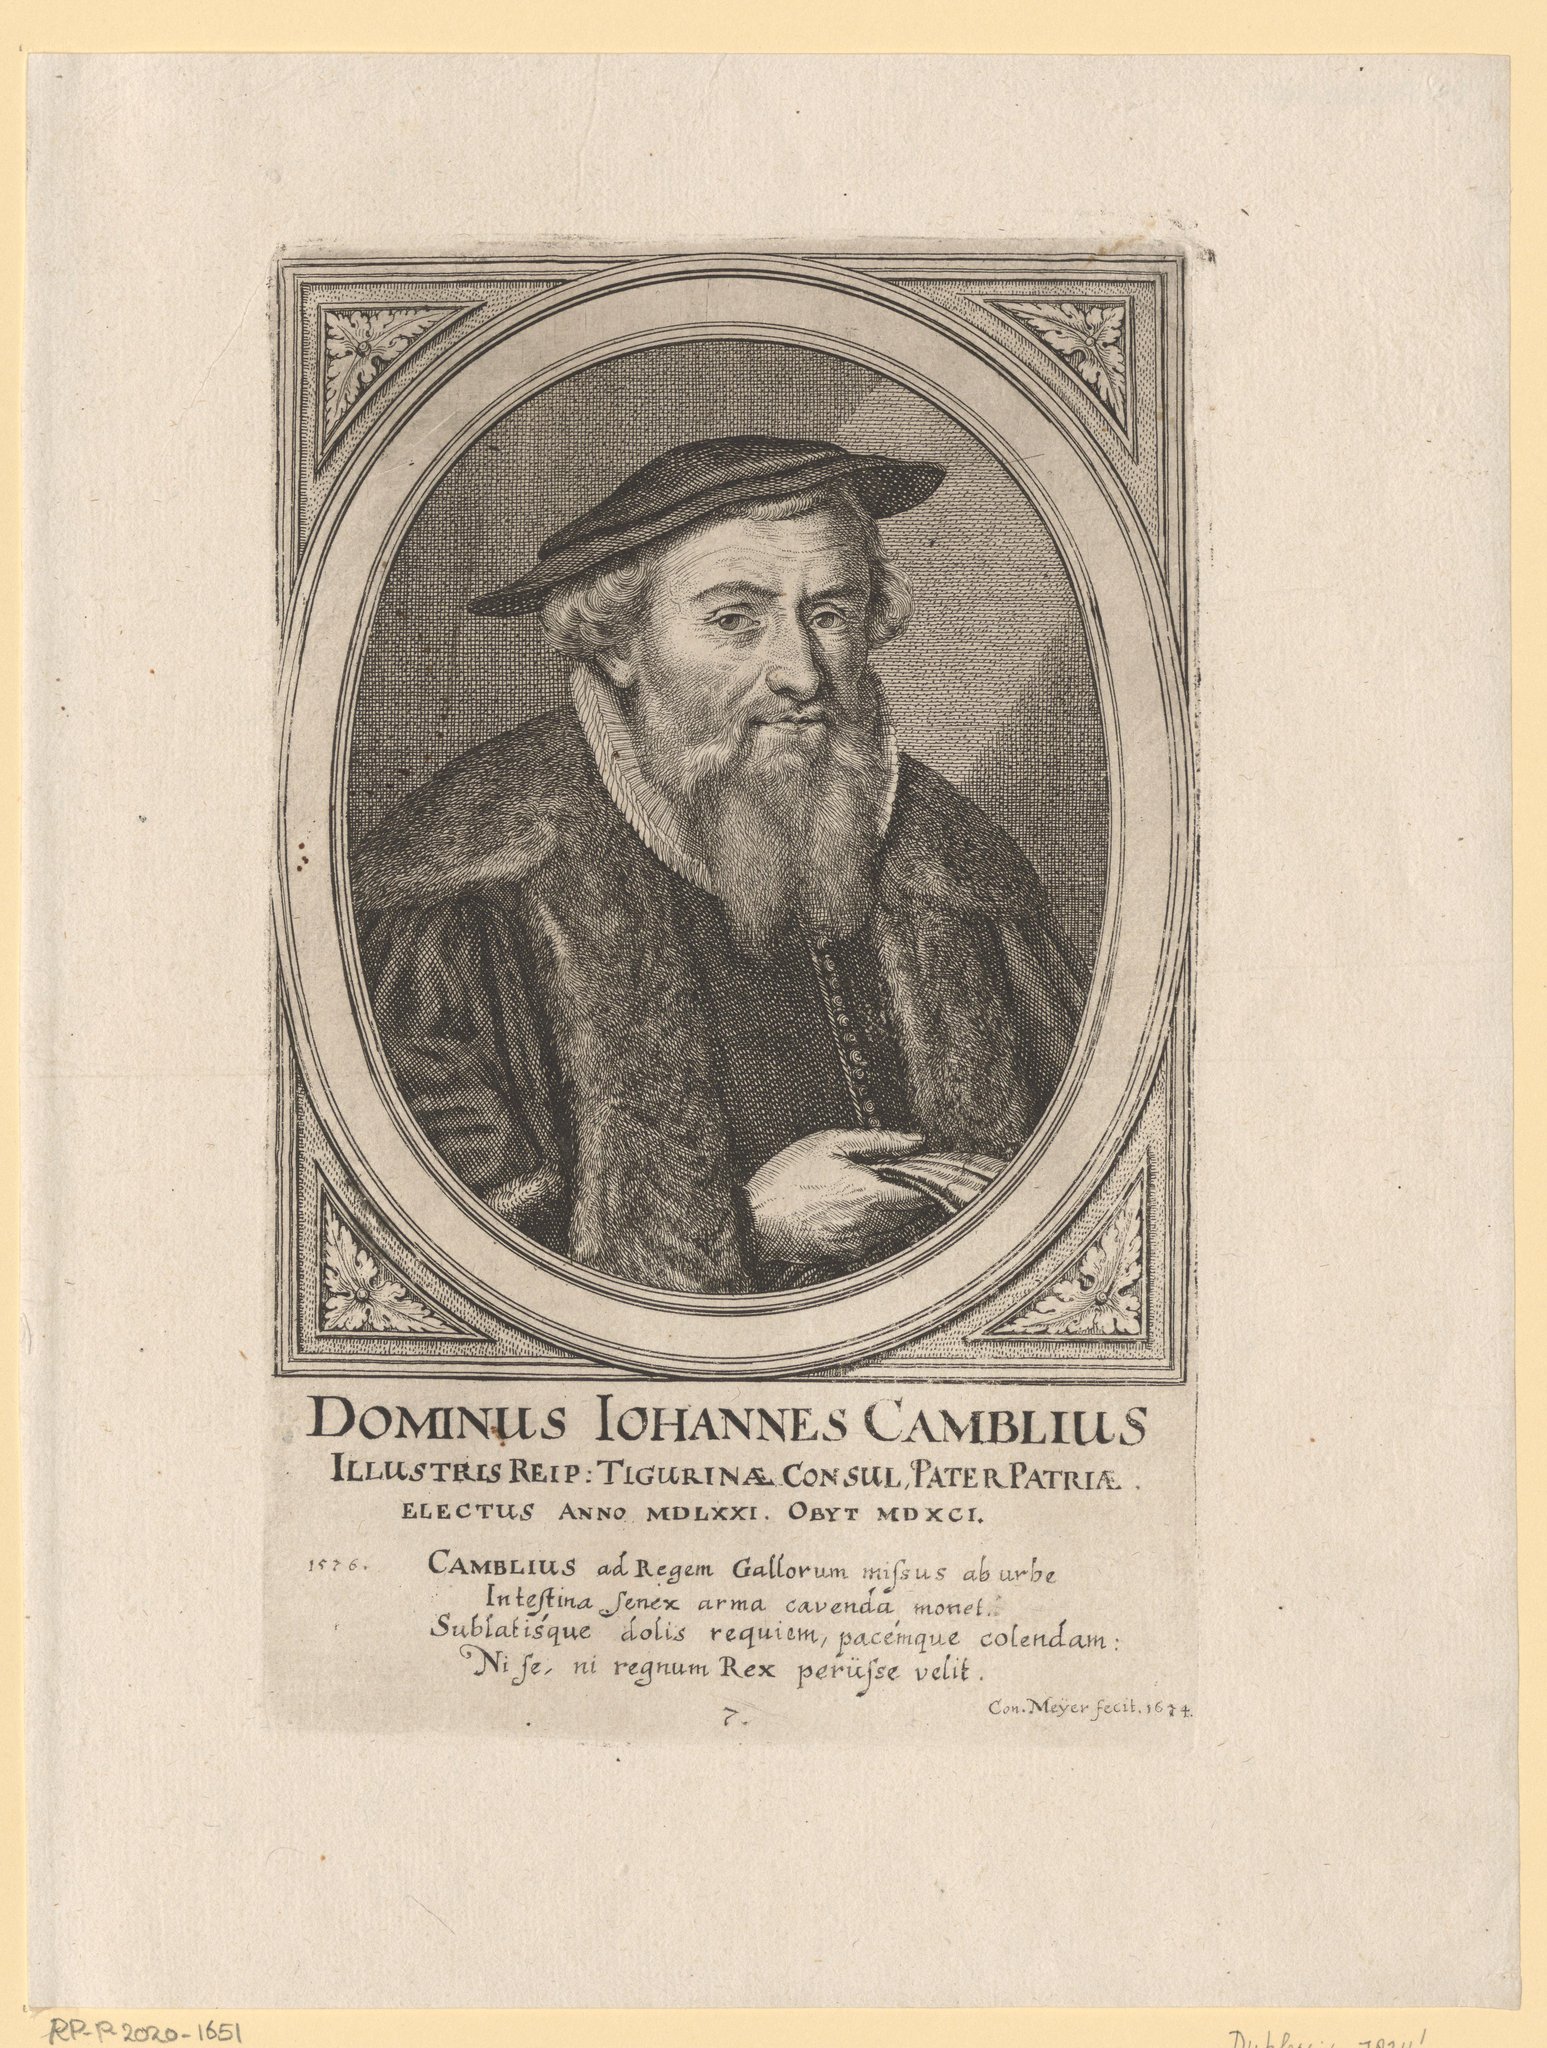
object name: print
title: Portret van Johann Kambli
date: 1576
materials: paper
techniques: engraving, etching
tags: mayor, historical persons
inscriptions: date